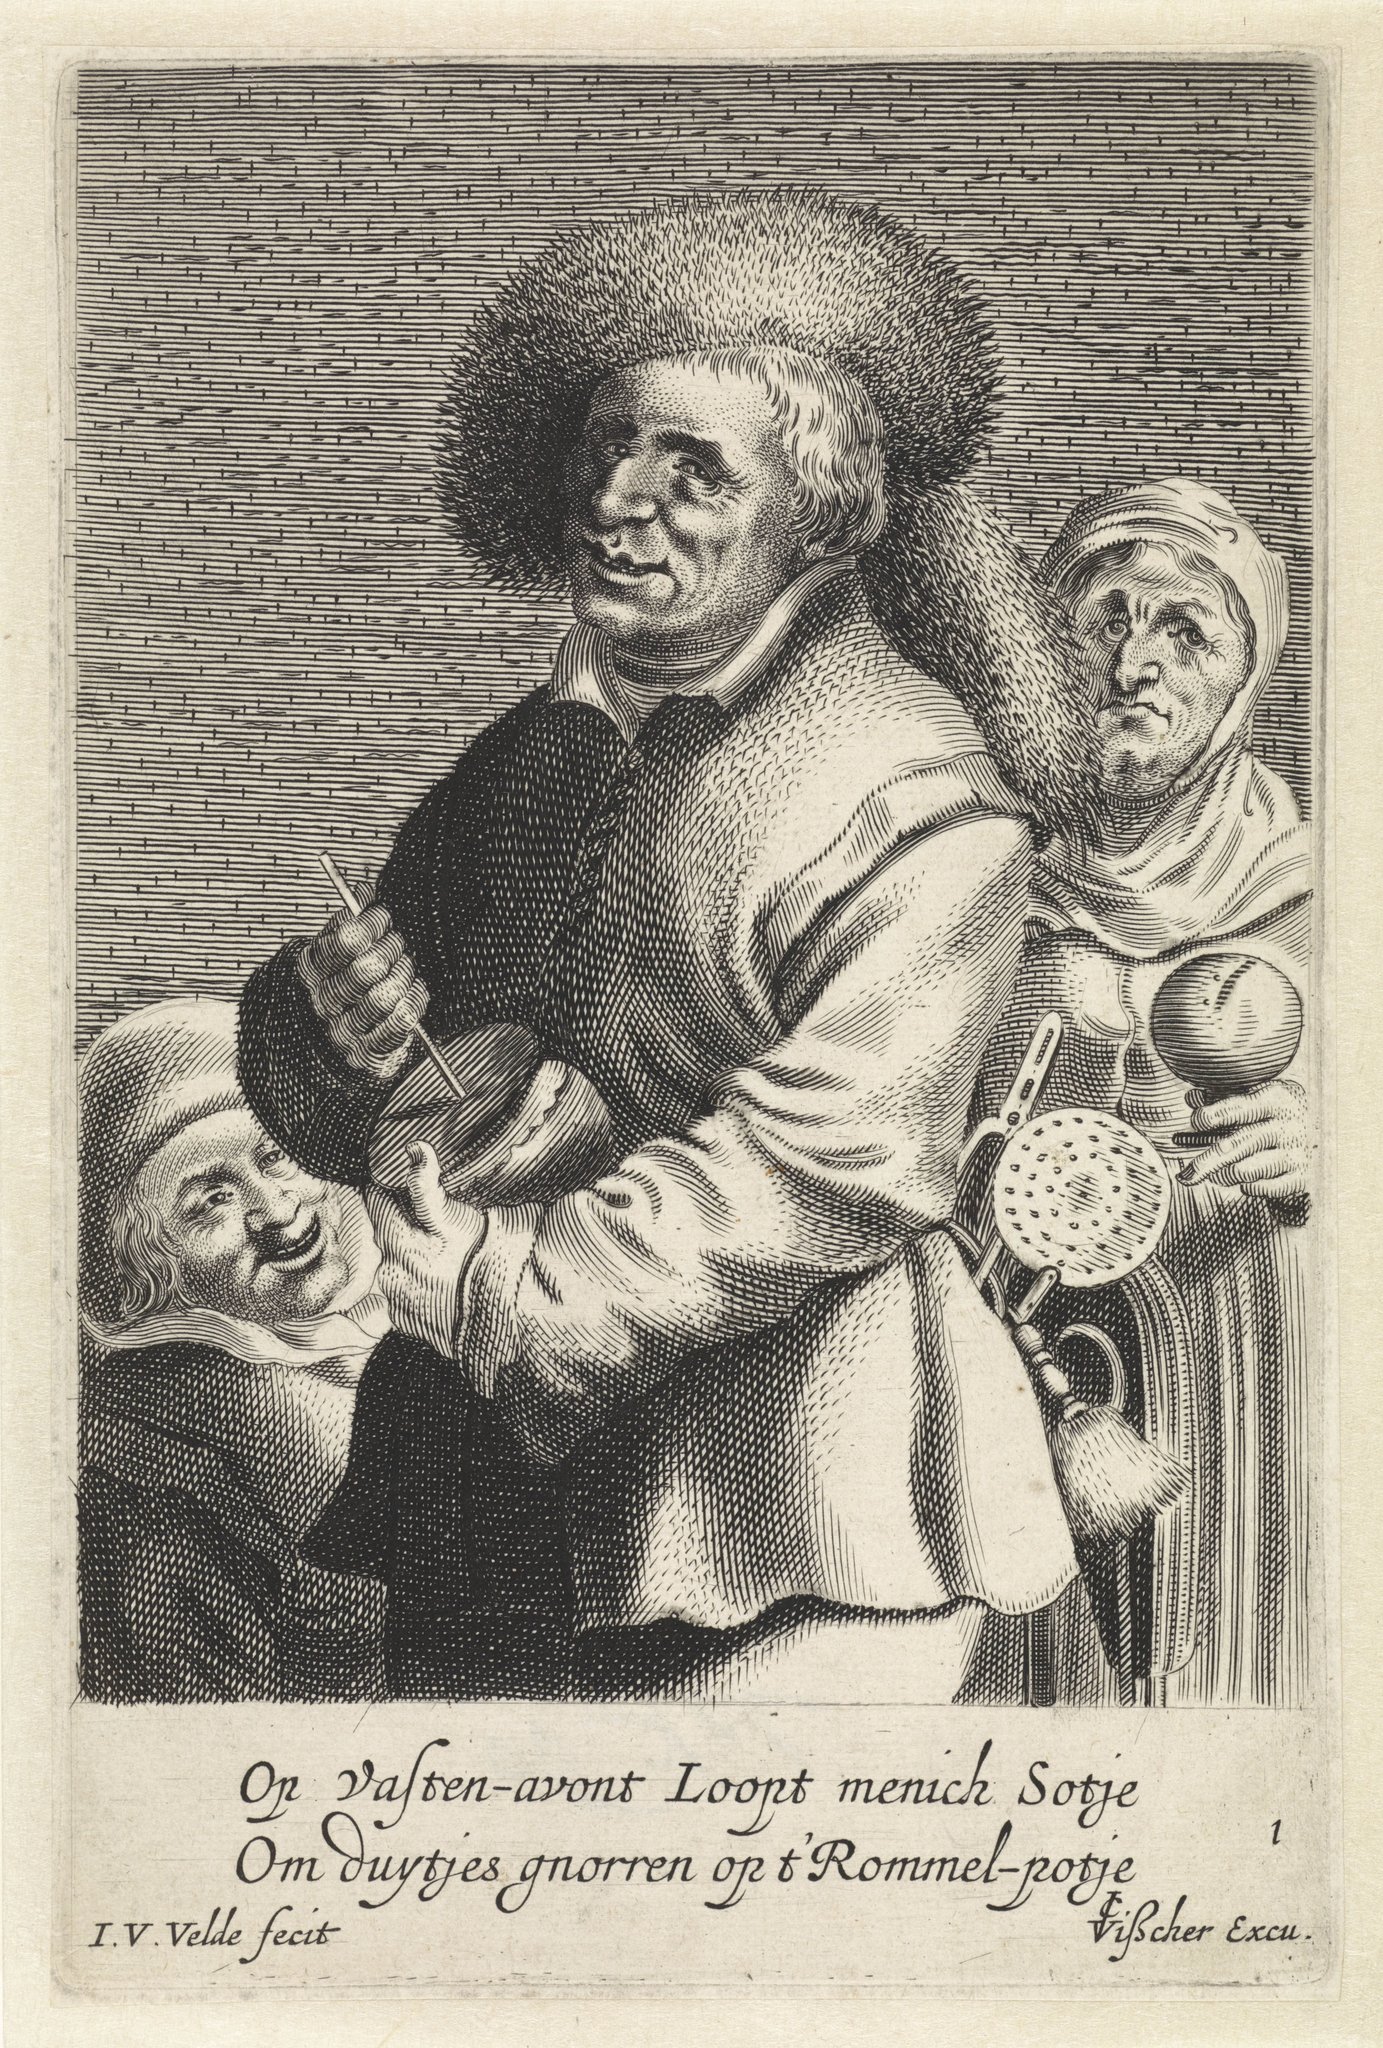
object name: print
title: Ambulante muzikanten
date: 1603-1652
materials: paper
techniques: engraving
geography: northern netherlands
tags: money-chest, treasure-chest, money-box (+ variant), improvised musical instruments: rumbling pot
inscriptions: collector's mark: Lugt 240, caption: ‘Op Vasten-avont Loopt mench Sotje / Om duytjes gnorren op 't Rommel-potje’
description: Een man met bontmuts op zijn hoofd bespeelt de rommelpot. Op zijn rug hangt keukengerei. Achter hem een oude vrouw met een spaarpot. Eeerst orent uit een serie van vier.